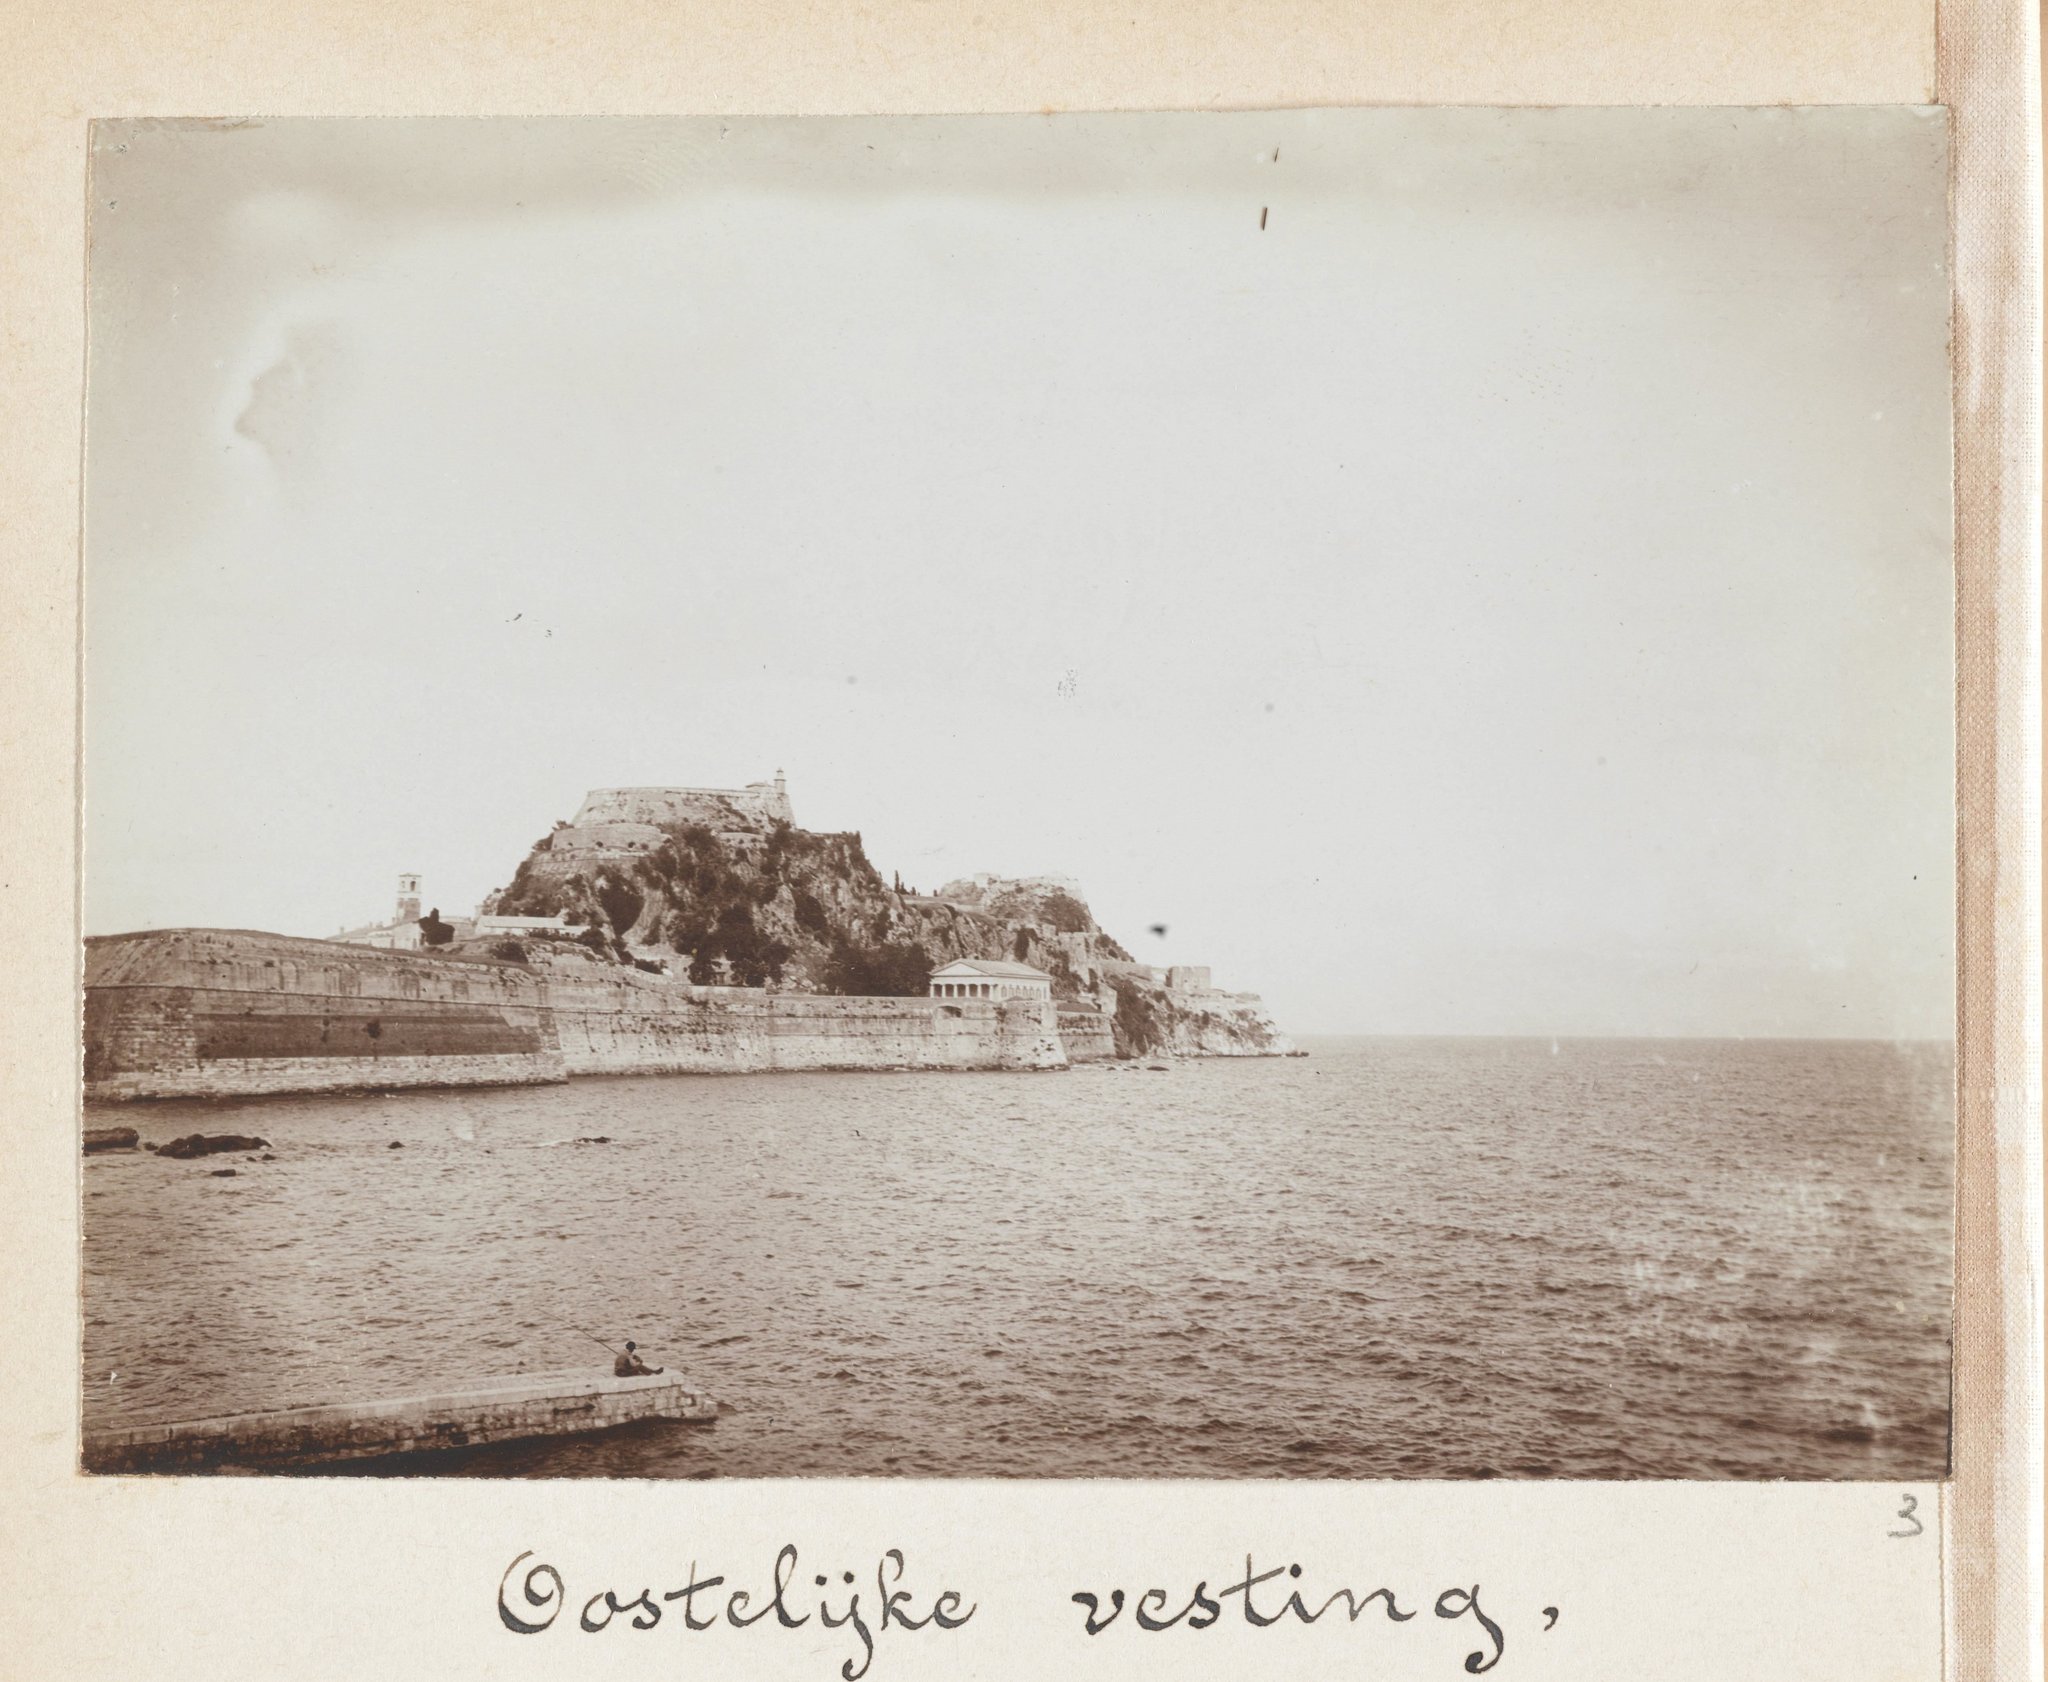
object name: photograph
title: Oostelijke vesting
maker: johannes lodewijk heldring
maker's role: fotograaf, predikant, schrijver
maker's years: 1852-1923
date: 1898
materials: paper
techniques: collodion silver print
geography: corfu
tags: fortress